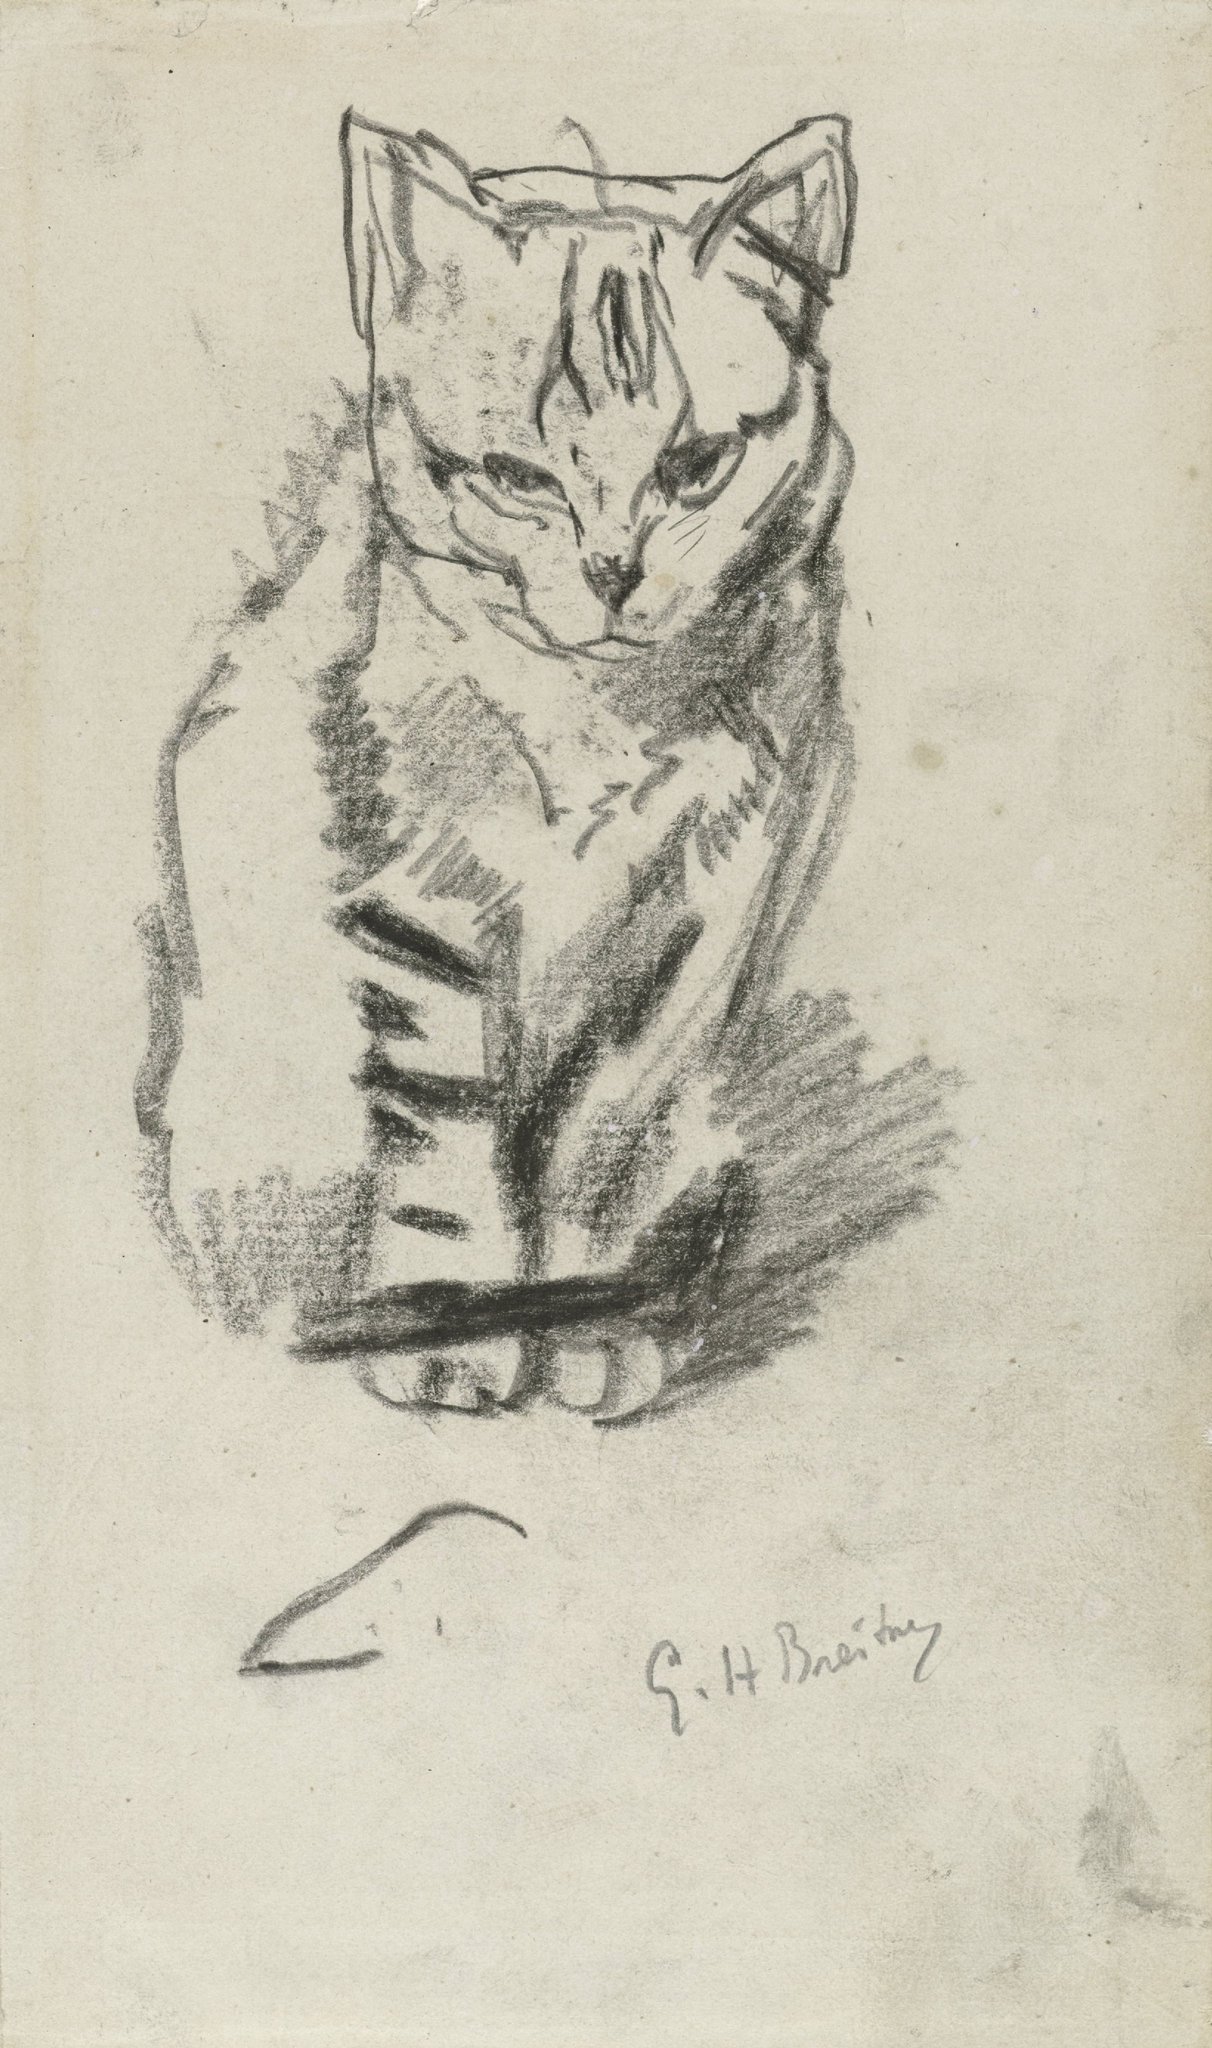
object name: drawing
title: Seated Pussycat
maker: george hendrik breitner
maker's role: draughtsman, painter, print maker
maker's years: 1857-1923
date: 1882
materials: chalk, paper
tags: cat